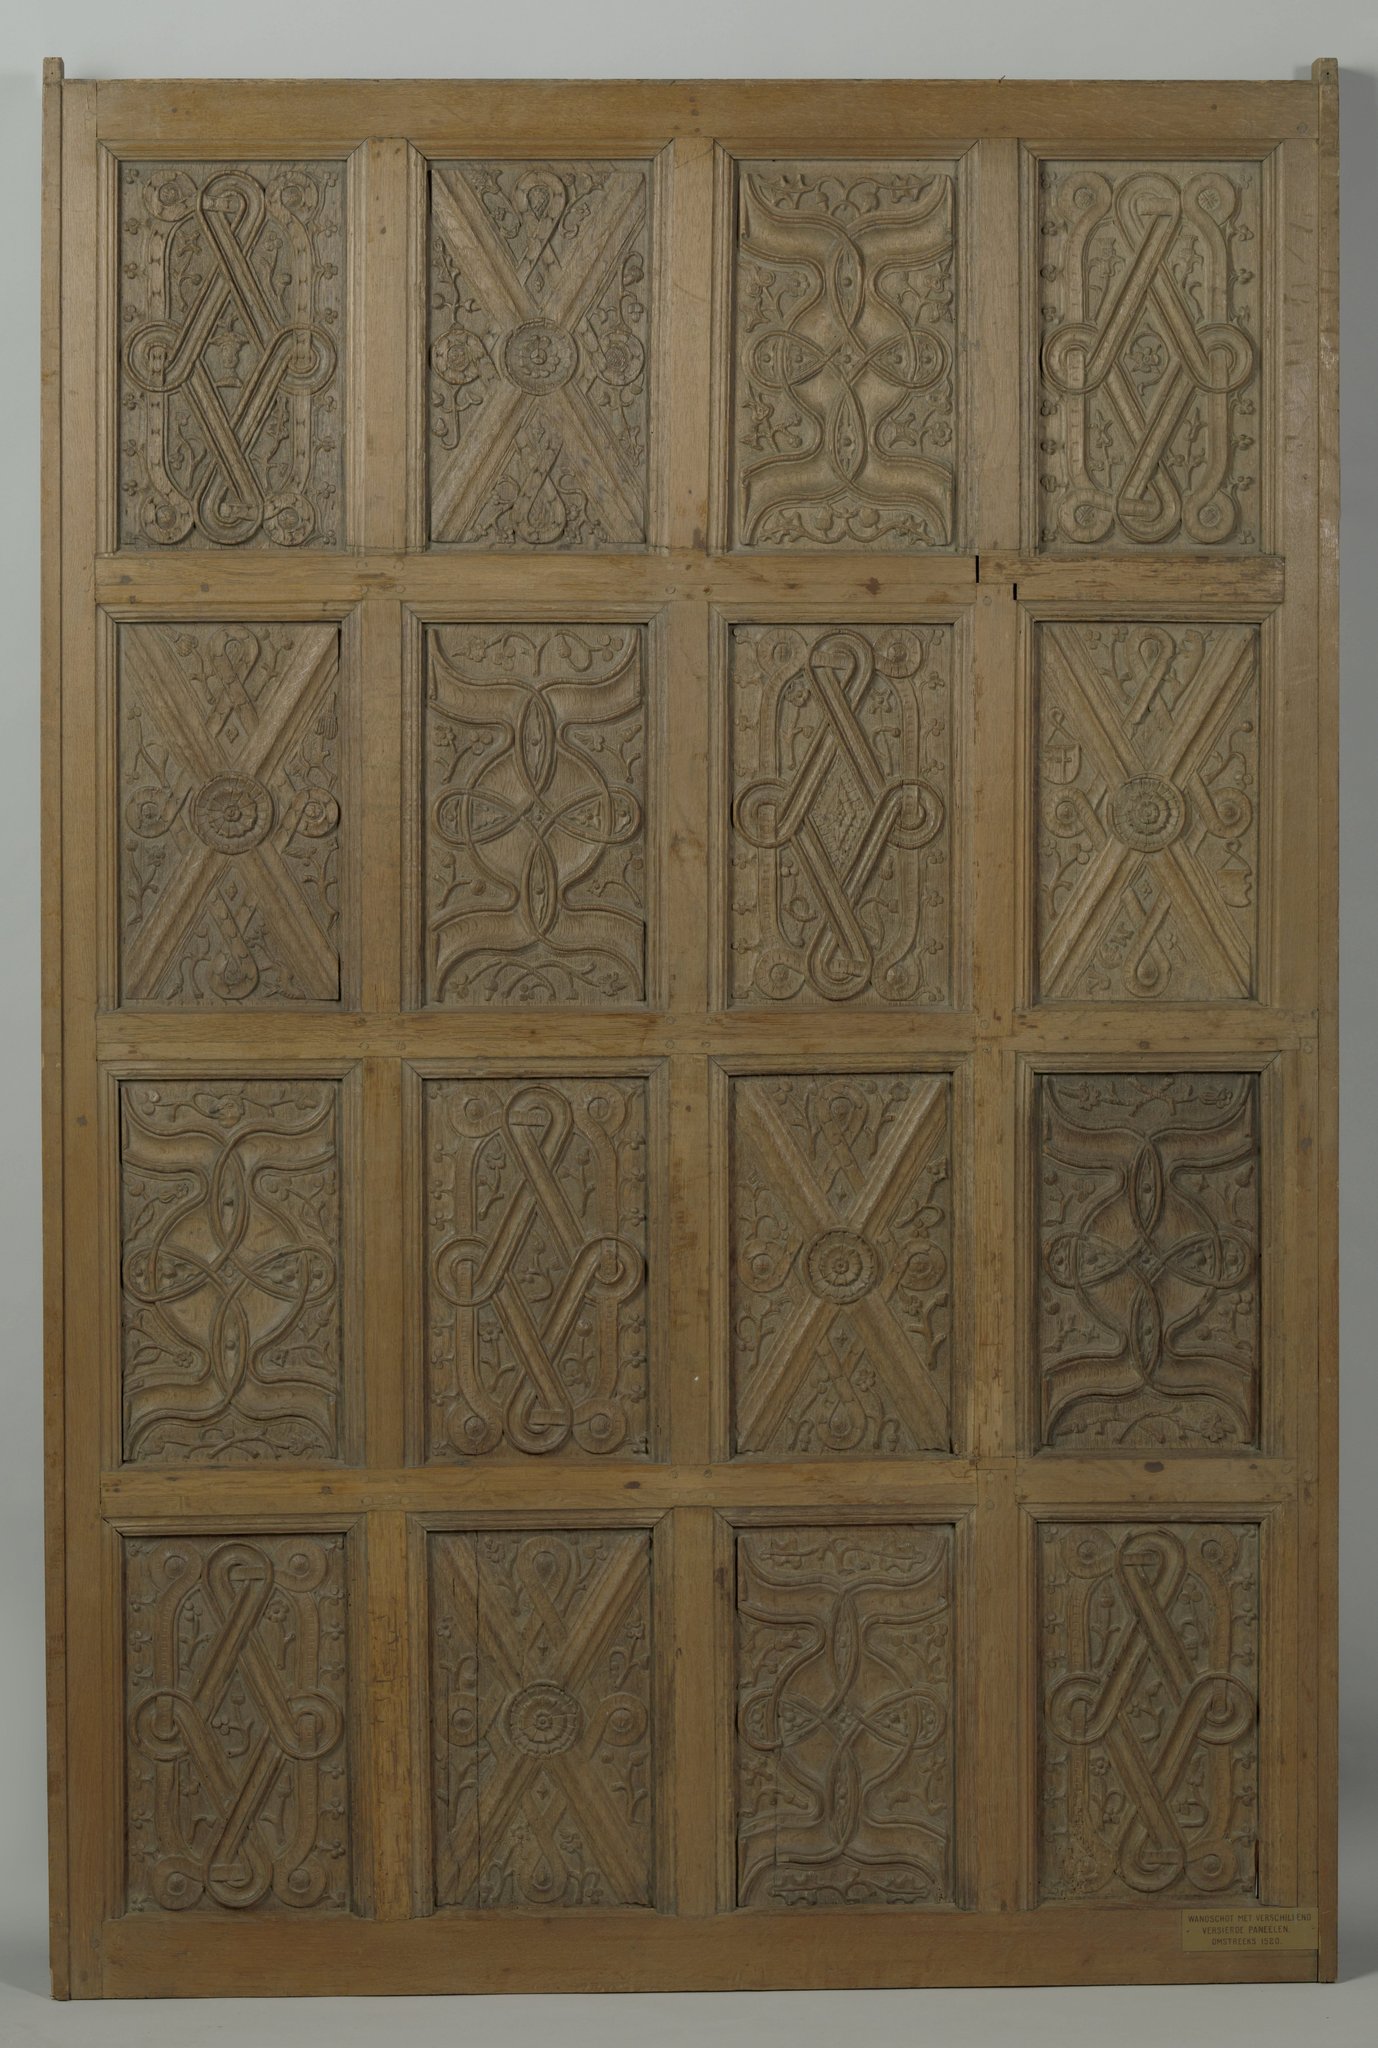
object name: betimmering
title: Houten schot met zestien panelen, divers versierd: bandslingers, Andreaskruis met bandvlechting, bandslinger met bandvlechting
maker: Anonymous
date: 1525-1550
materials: wood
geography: netherlands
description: Een schot, oorspronkelijk van een betimmering van eikenhout, bestaande uit zestien panelen. Er zijn drie soorten versiering te onderscheiden: bandslingers met middenrug, Andreaskruis met bandvlechting, bandslinger met bandvlechting. In de uitgrondingen hebben zij alle losse takjes. Deels vernieuwd.